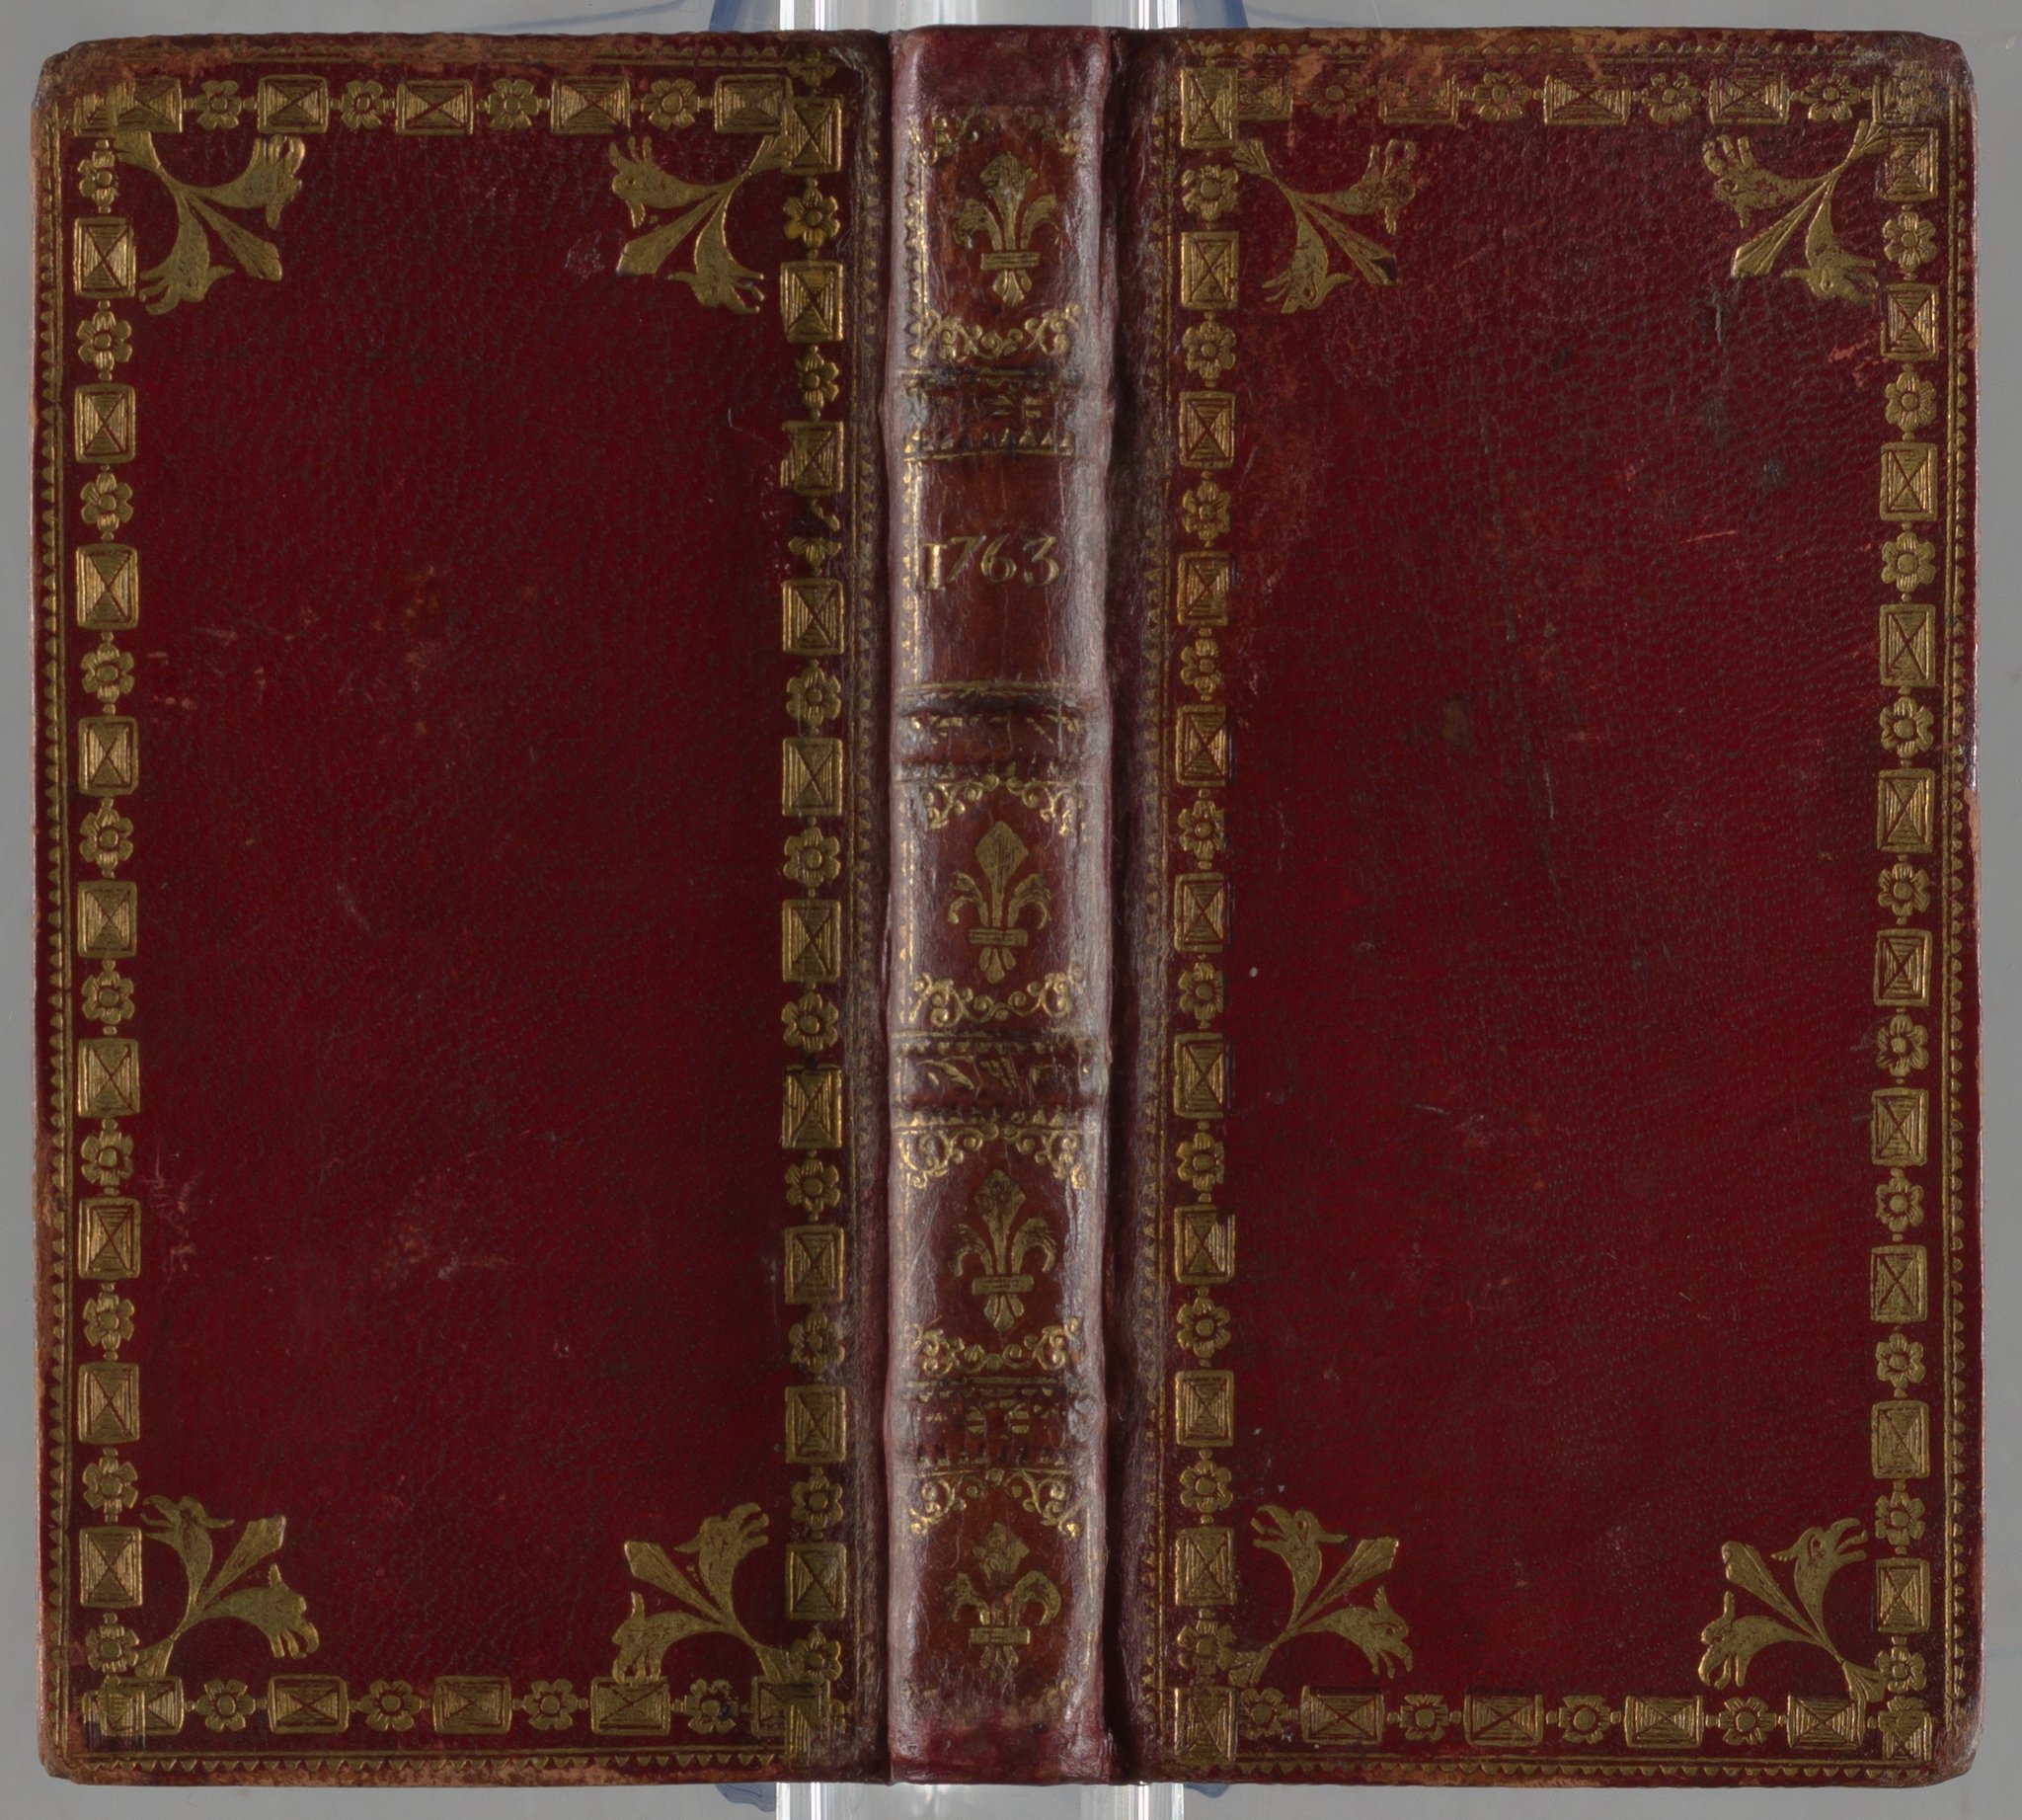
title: Les Spectacles de Paris, ou, Calendrier historique & chronologique des théâtres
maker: joseph de laporte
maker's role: editor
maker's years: 1713-1779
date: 1763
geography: france